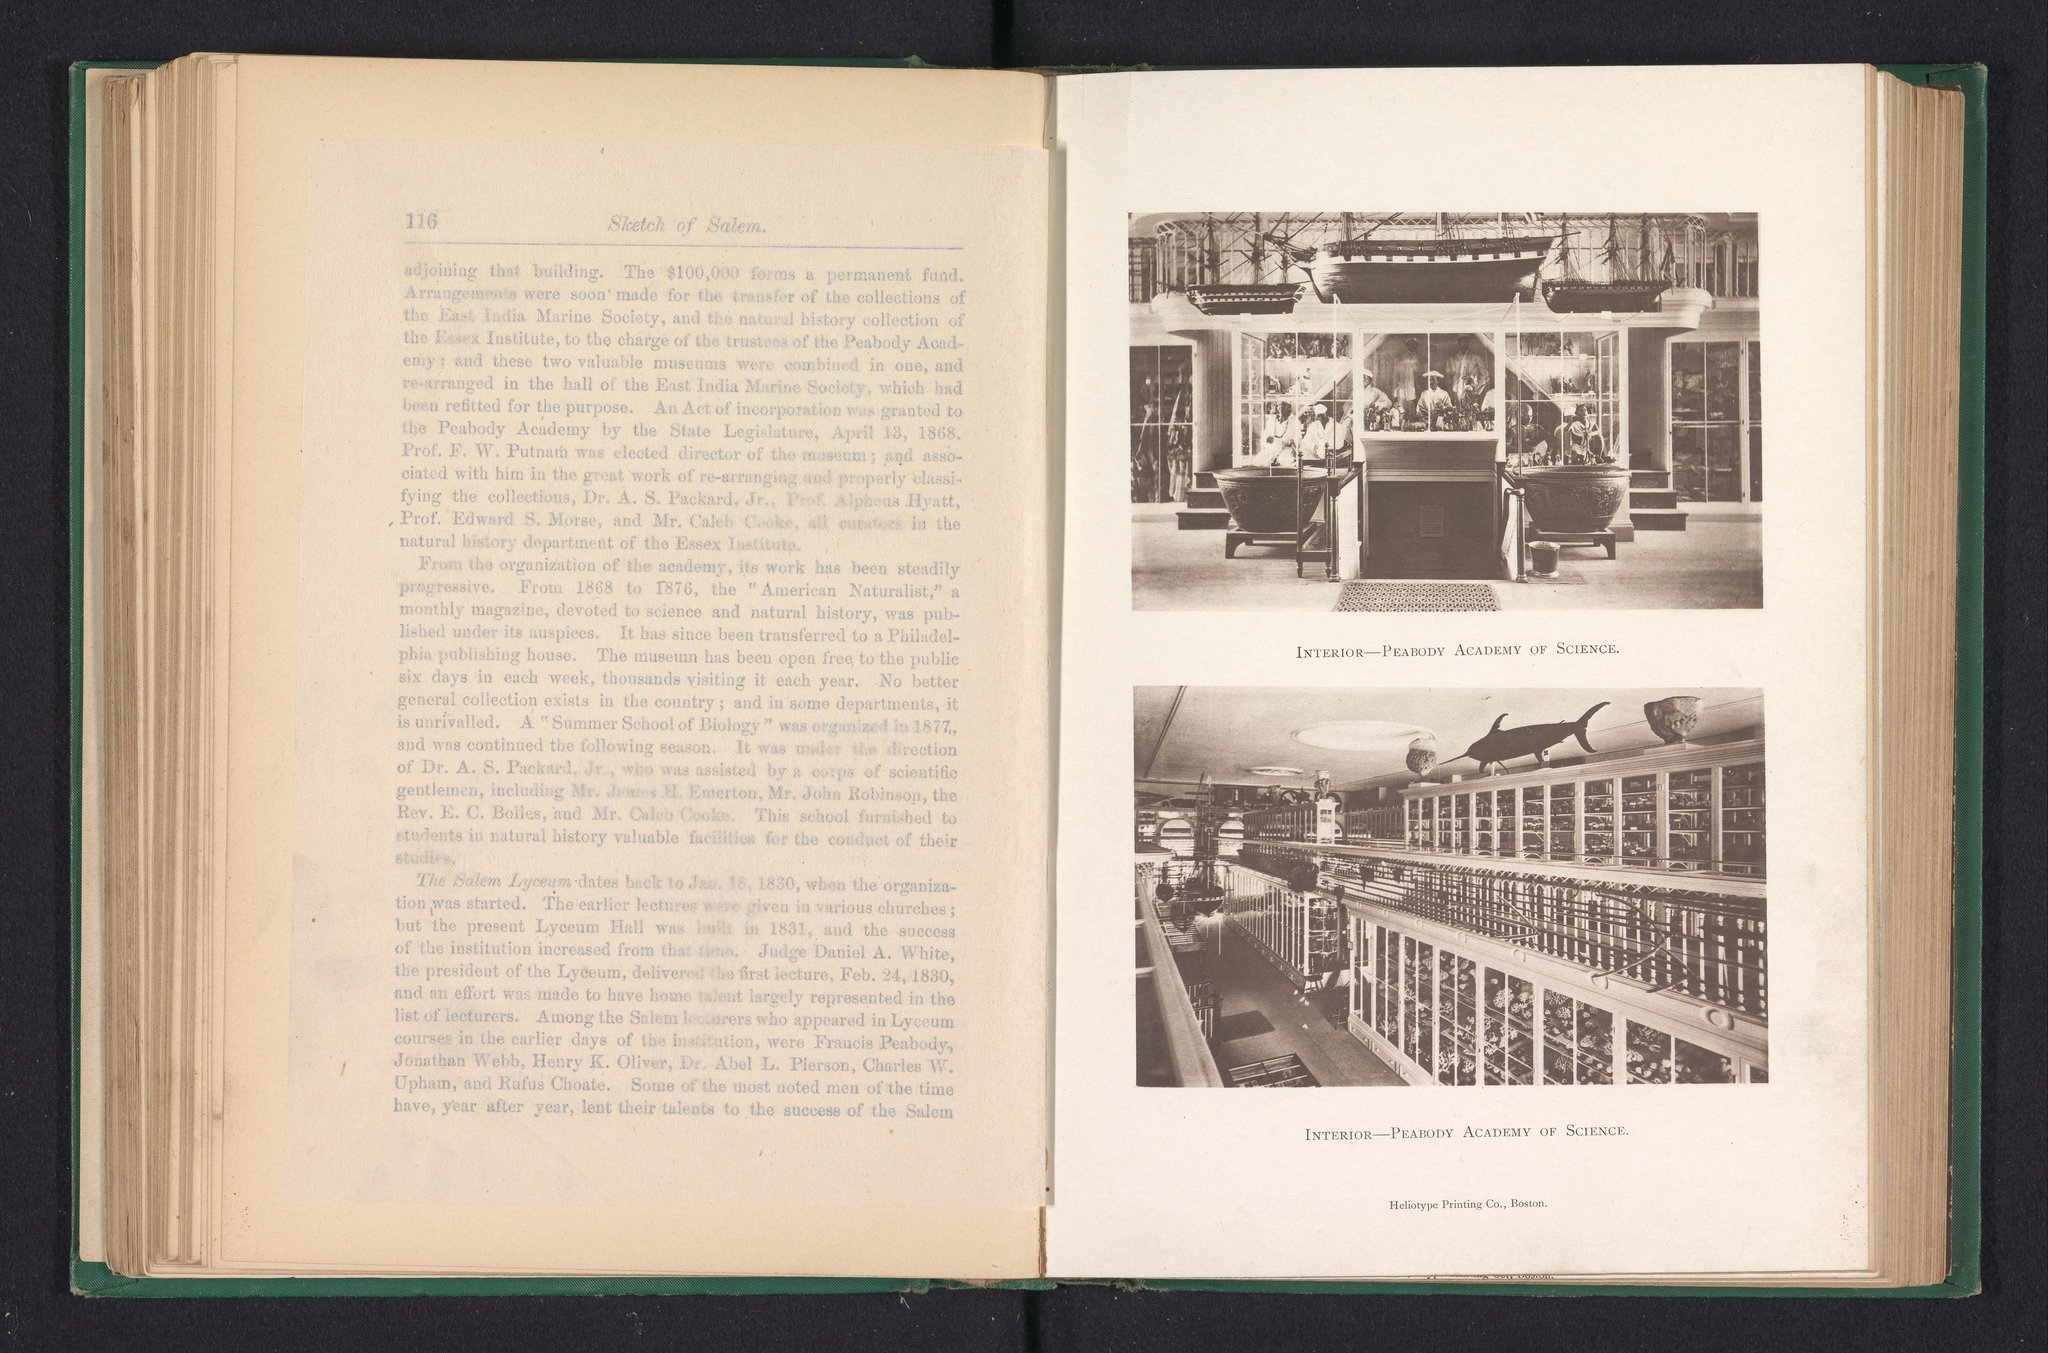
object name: photomechanical print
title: Interior-Peabody Academy of Science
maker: Anonymous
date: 1804-1879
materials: paper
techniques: photoaquatint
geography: salem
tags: permanent exhibition, museum